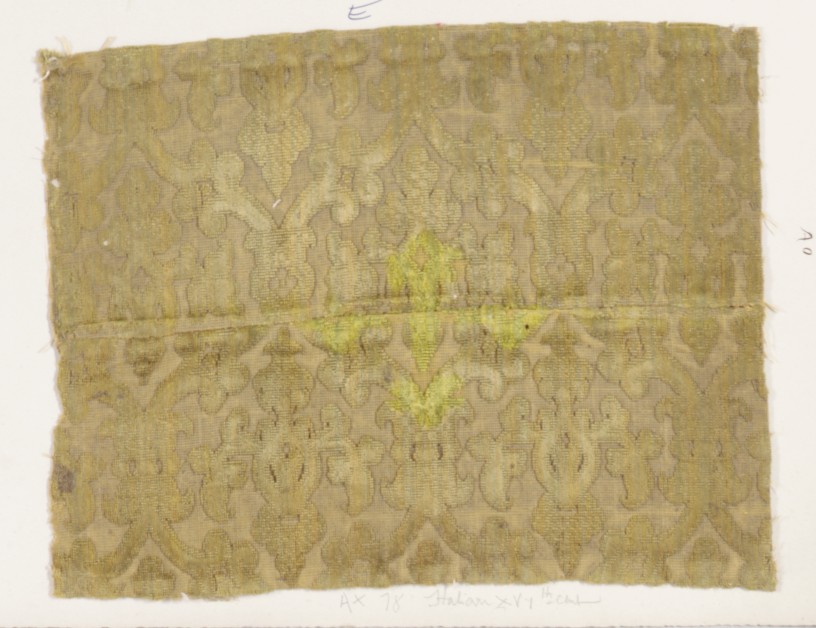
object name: fragment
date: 1501-1700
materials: metal thread, silk